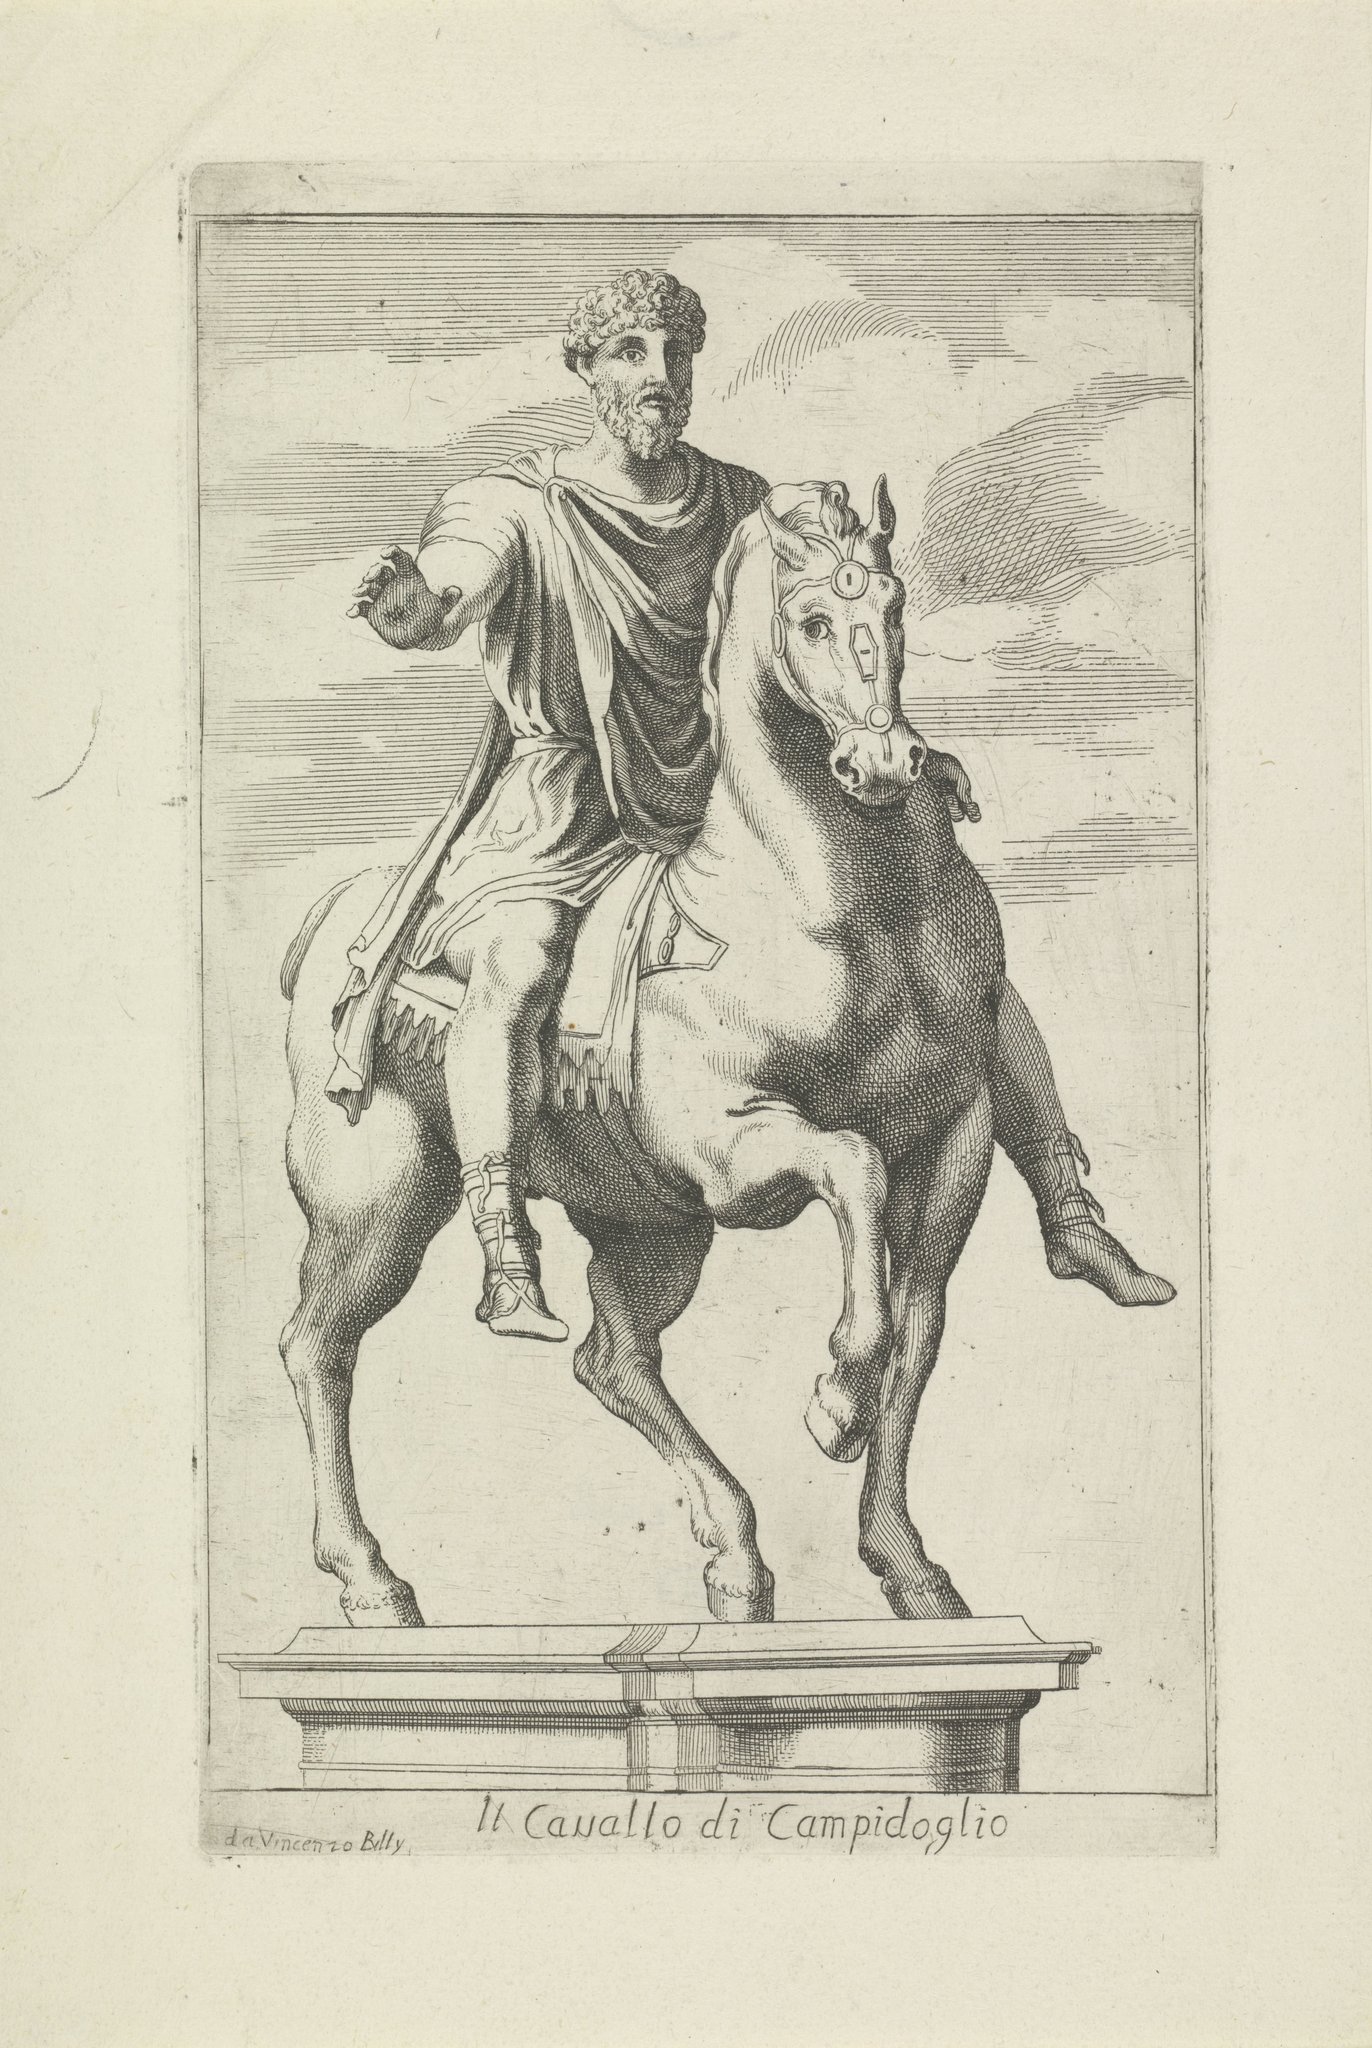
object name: print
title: Il Cavallo di Campidoglio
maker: vincent belly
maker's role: print maker, publisher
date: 1600-1699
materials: paper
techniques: etching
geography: italy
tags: rome, equestrian statue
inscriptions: collector's mark: Lugt 2228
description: Het ruiterstandbeeld van Marcus Aurelius op Piazza del Campidoglio in Rome.